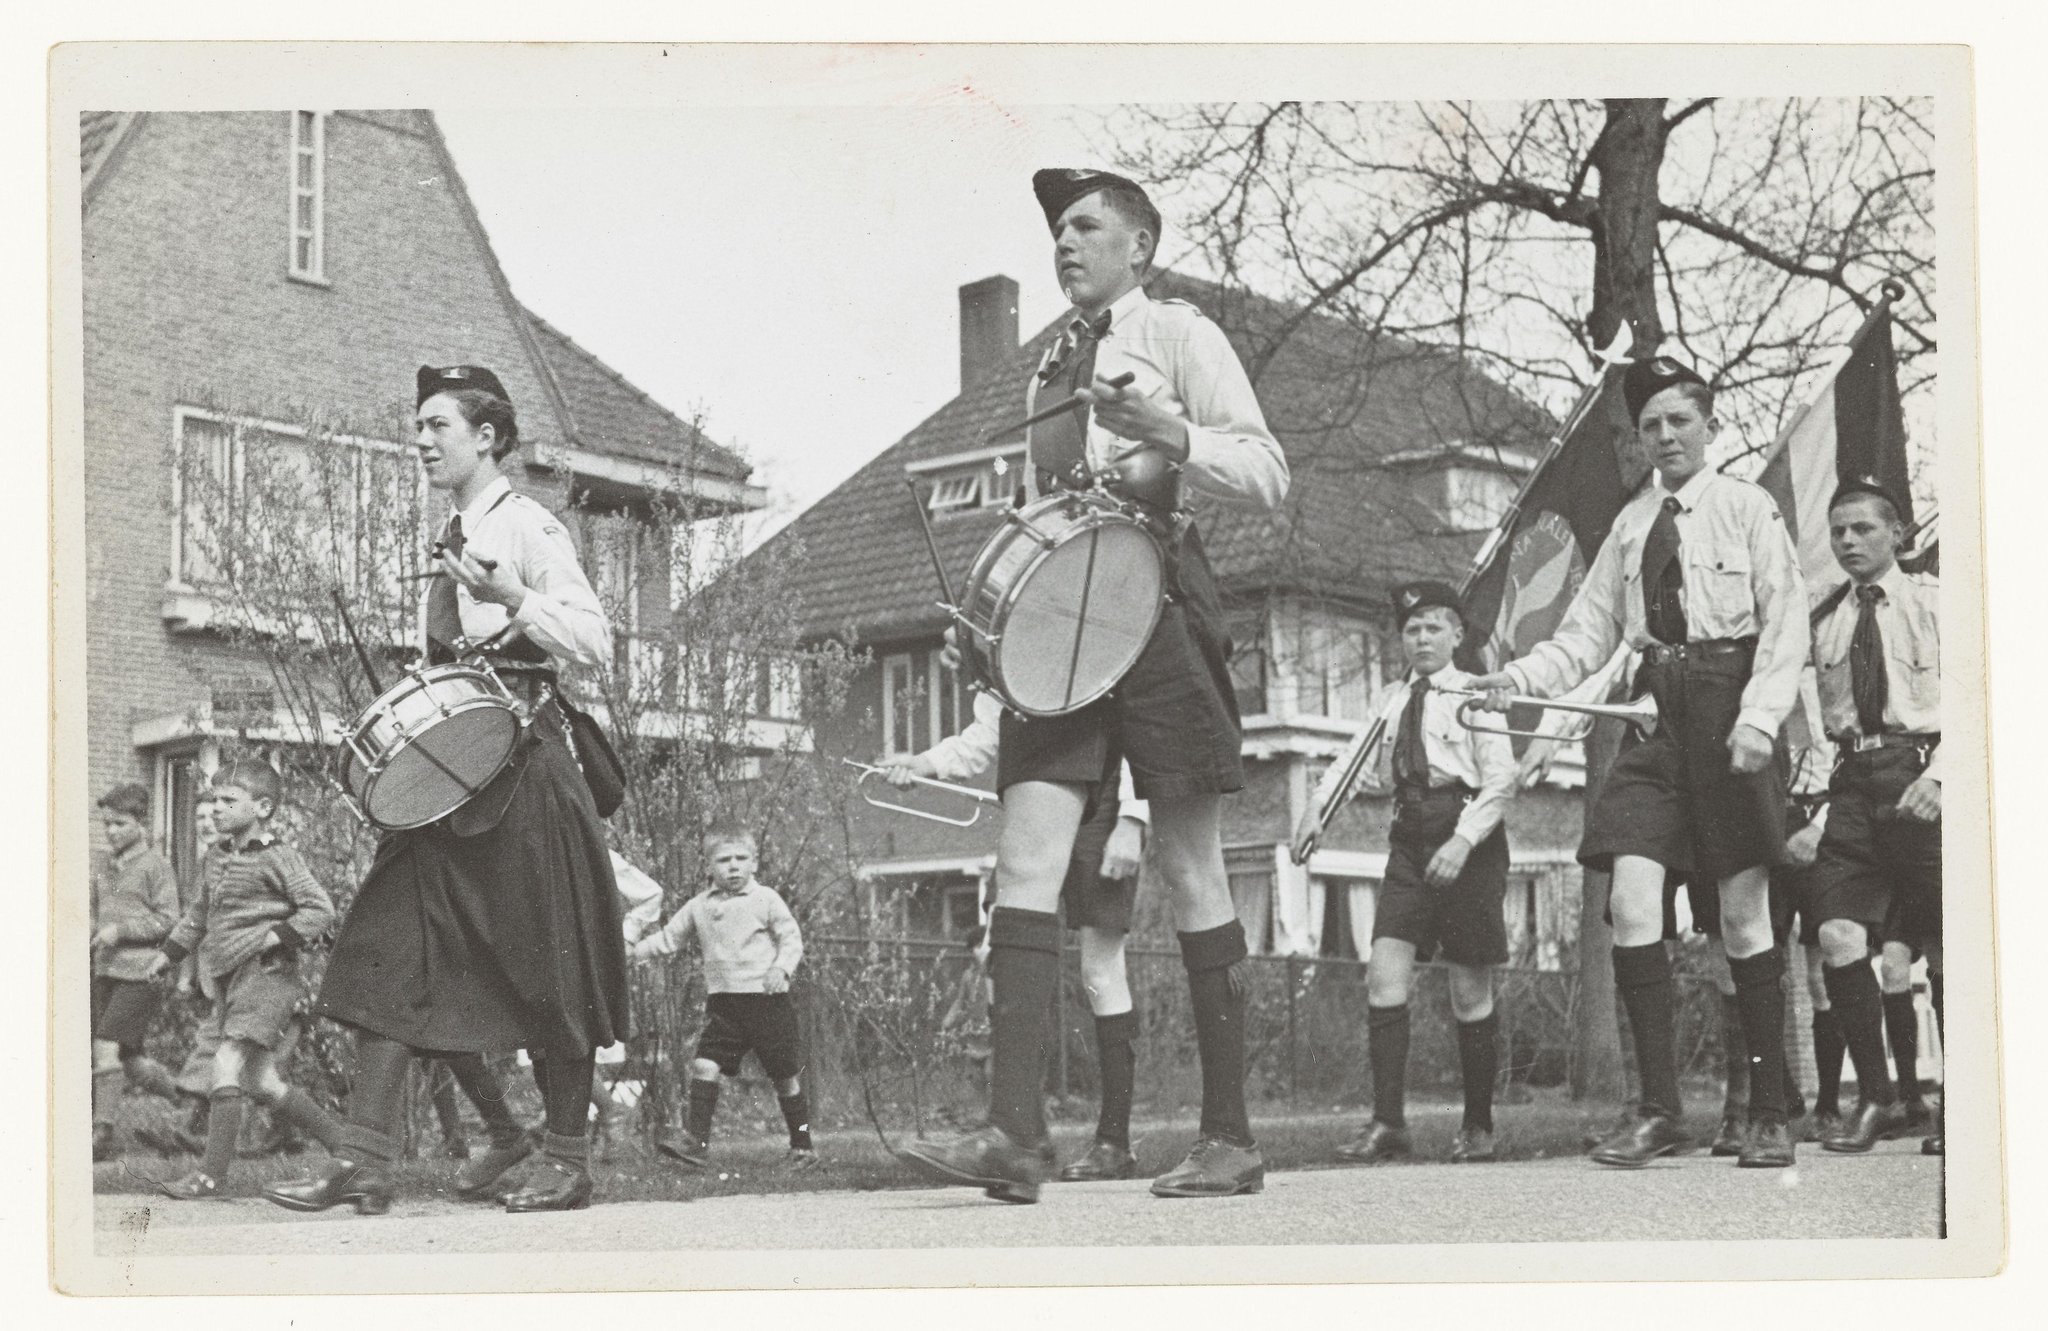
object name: photograph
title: Optocht Jeugdstorm met trommels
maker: j. otto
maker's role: fotograaf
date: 1935-1937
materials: photographic support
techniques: photography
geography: netherlands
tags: military music, military parade, pageant, netherlands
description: Groep leden van de Jeugdstorm, met een meisje en een jongen met een trommel voorop, lopen door een straat met villa's. Achter hen alleen jongens, twee met een trompet, en twee met een vlag, de Nederlandse en die van de Jeugdstorm. Allen in uniform. Een paar kleine kinderen lopen met hen mee.